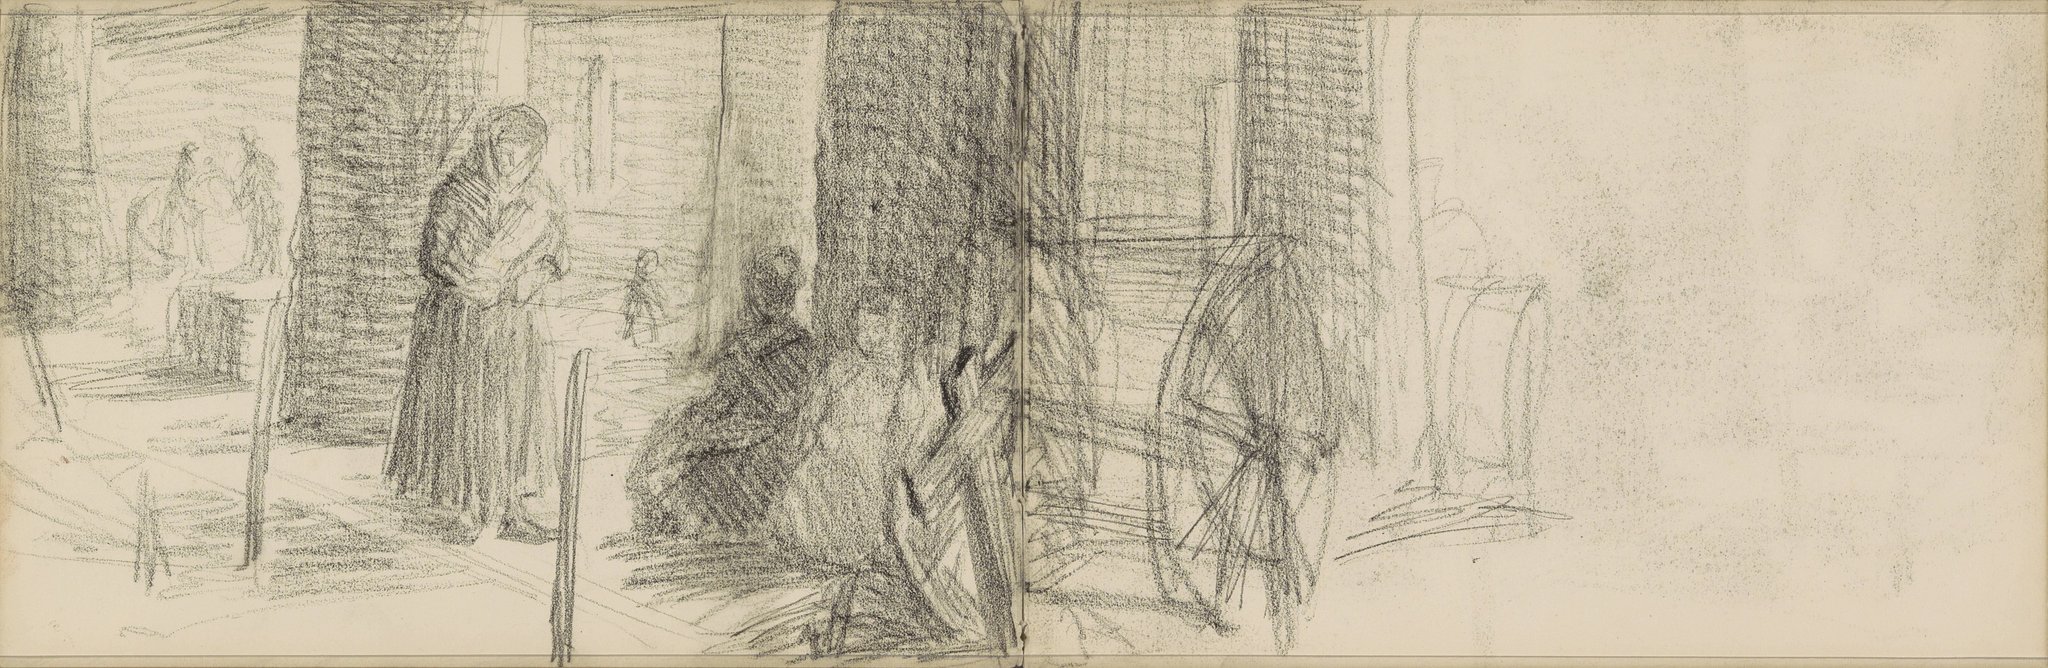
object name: sketchbook leaf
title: Figuren op een galerij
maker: a.a.l. de grammont-hubrecht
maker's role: draughtsman, painter, print maker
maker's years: 1855-1913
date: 1865-1913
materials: chalk, paper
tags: standing figure, sitting figure, colonnade, workshop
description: Mogelijk een werkplaats. Naast de zittende figuren staat een rad. Blad 60 verso en 61 recto uit een schetsboek met 65 bladen.